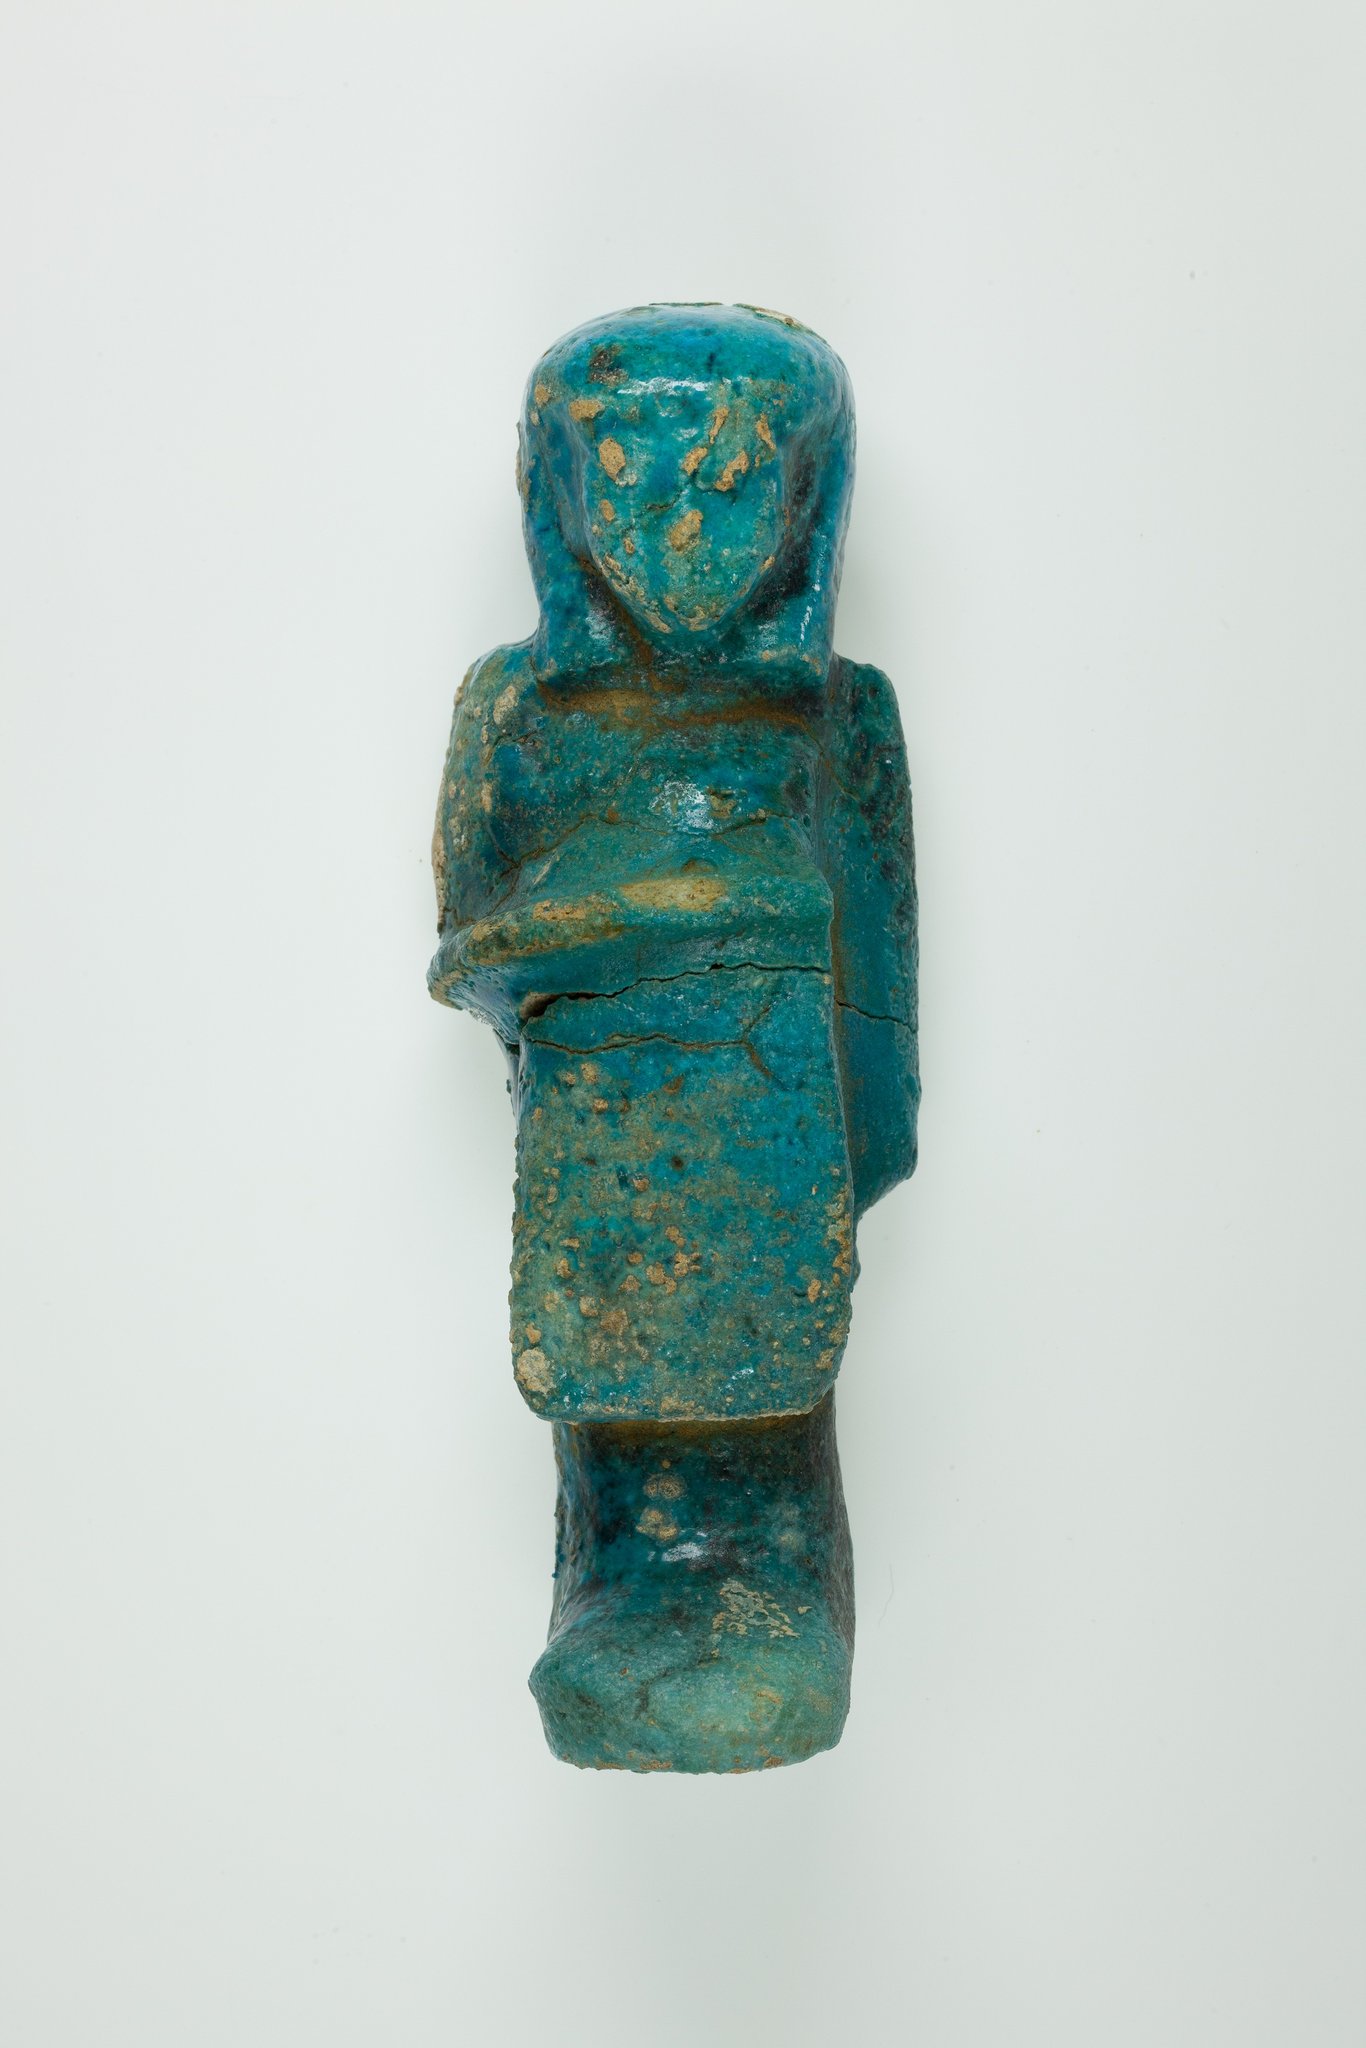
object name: overseer shabti, henettawy c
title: Overseer Shabti of Henettawy (C), Daughter of Isetemkheb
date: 990-970 BCE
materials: faience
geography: egypt